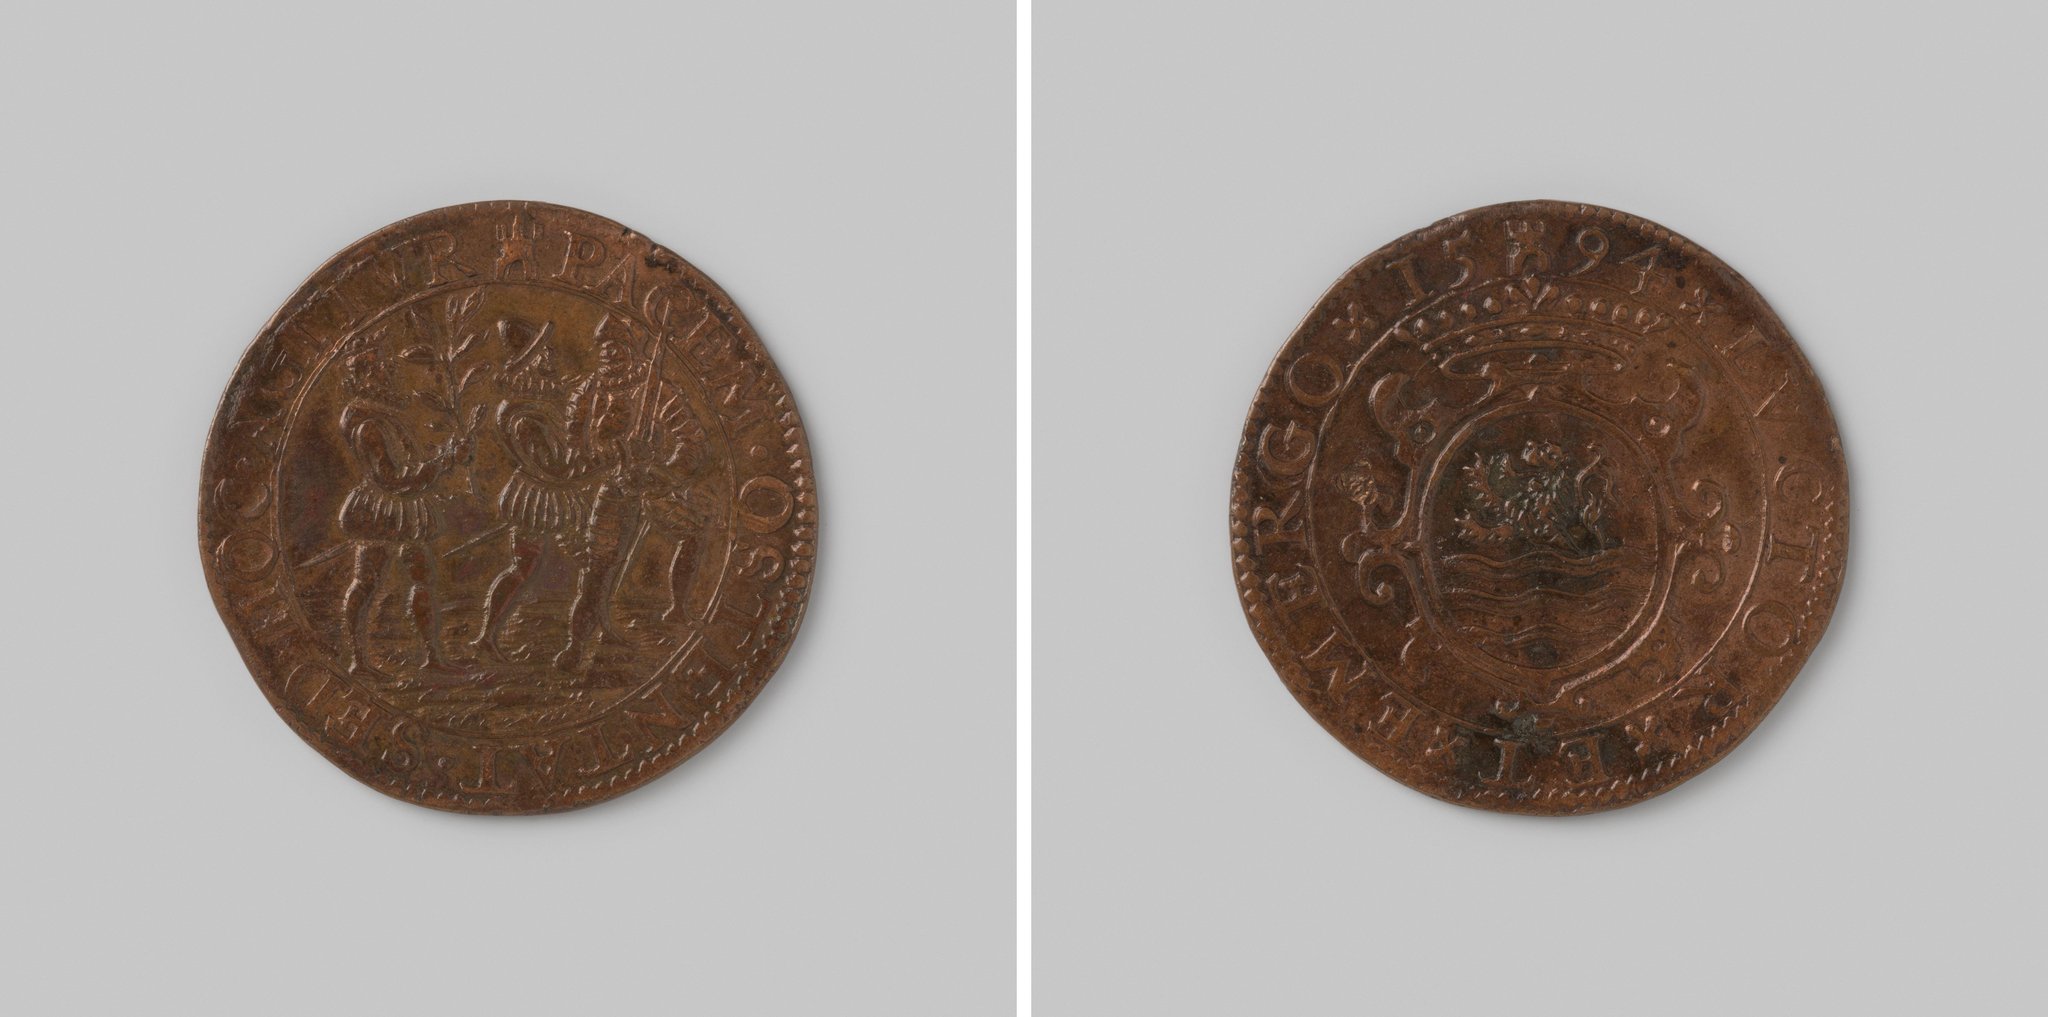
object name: jeton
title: Rekenpenning uit Middelburg op het verwerpen van vredesonderhandelingen 1594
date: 1594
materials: copper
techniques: striking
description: Koperen penning, op de voorzijde de Spaanse koning met olijftak met een Nederlander die door een Spaans soldaat wordt aangevallen, met omschrift, op de keerzijde het gekroonde ovale wapenschild van Zeeland in een cartouche, met omschrift.